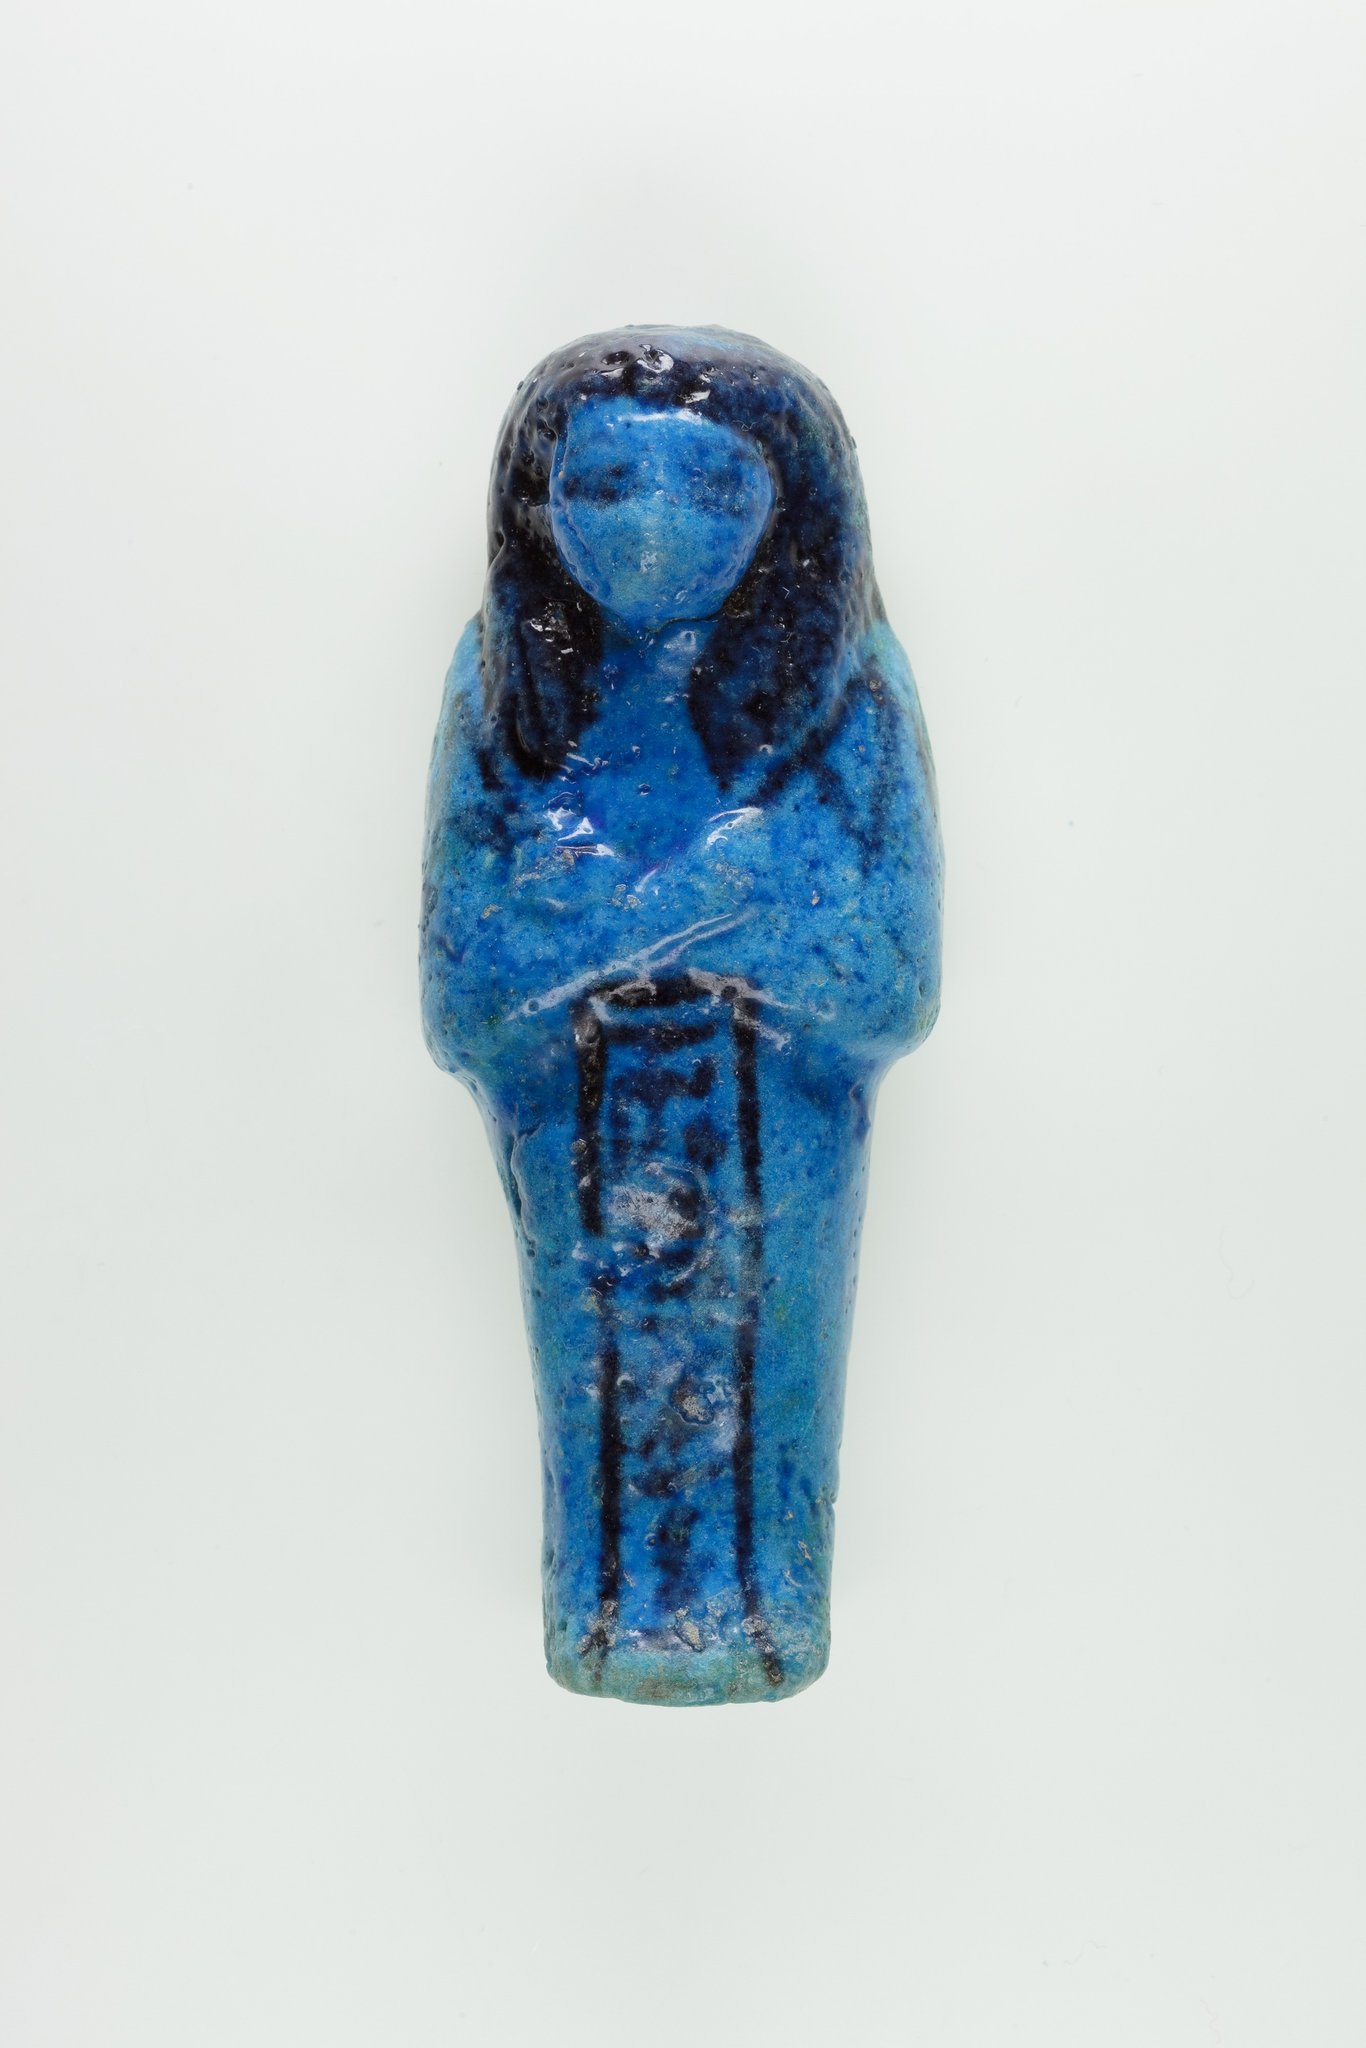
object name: shabti, worker, nauny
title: Worker Shabti of Nauny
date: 1050 BCE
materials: faience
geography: egypt